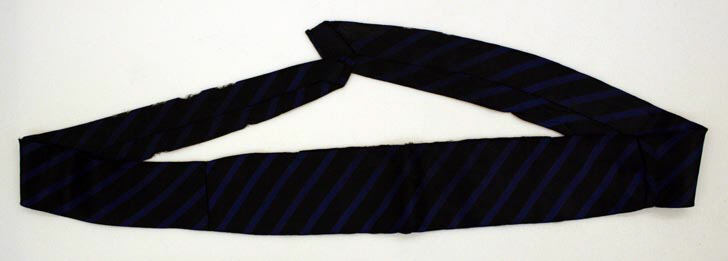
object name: neckcloth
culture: european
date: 1840-1849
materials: silk